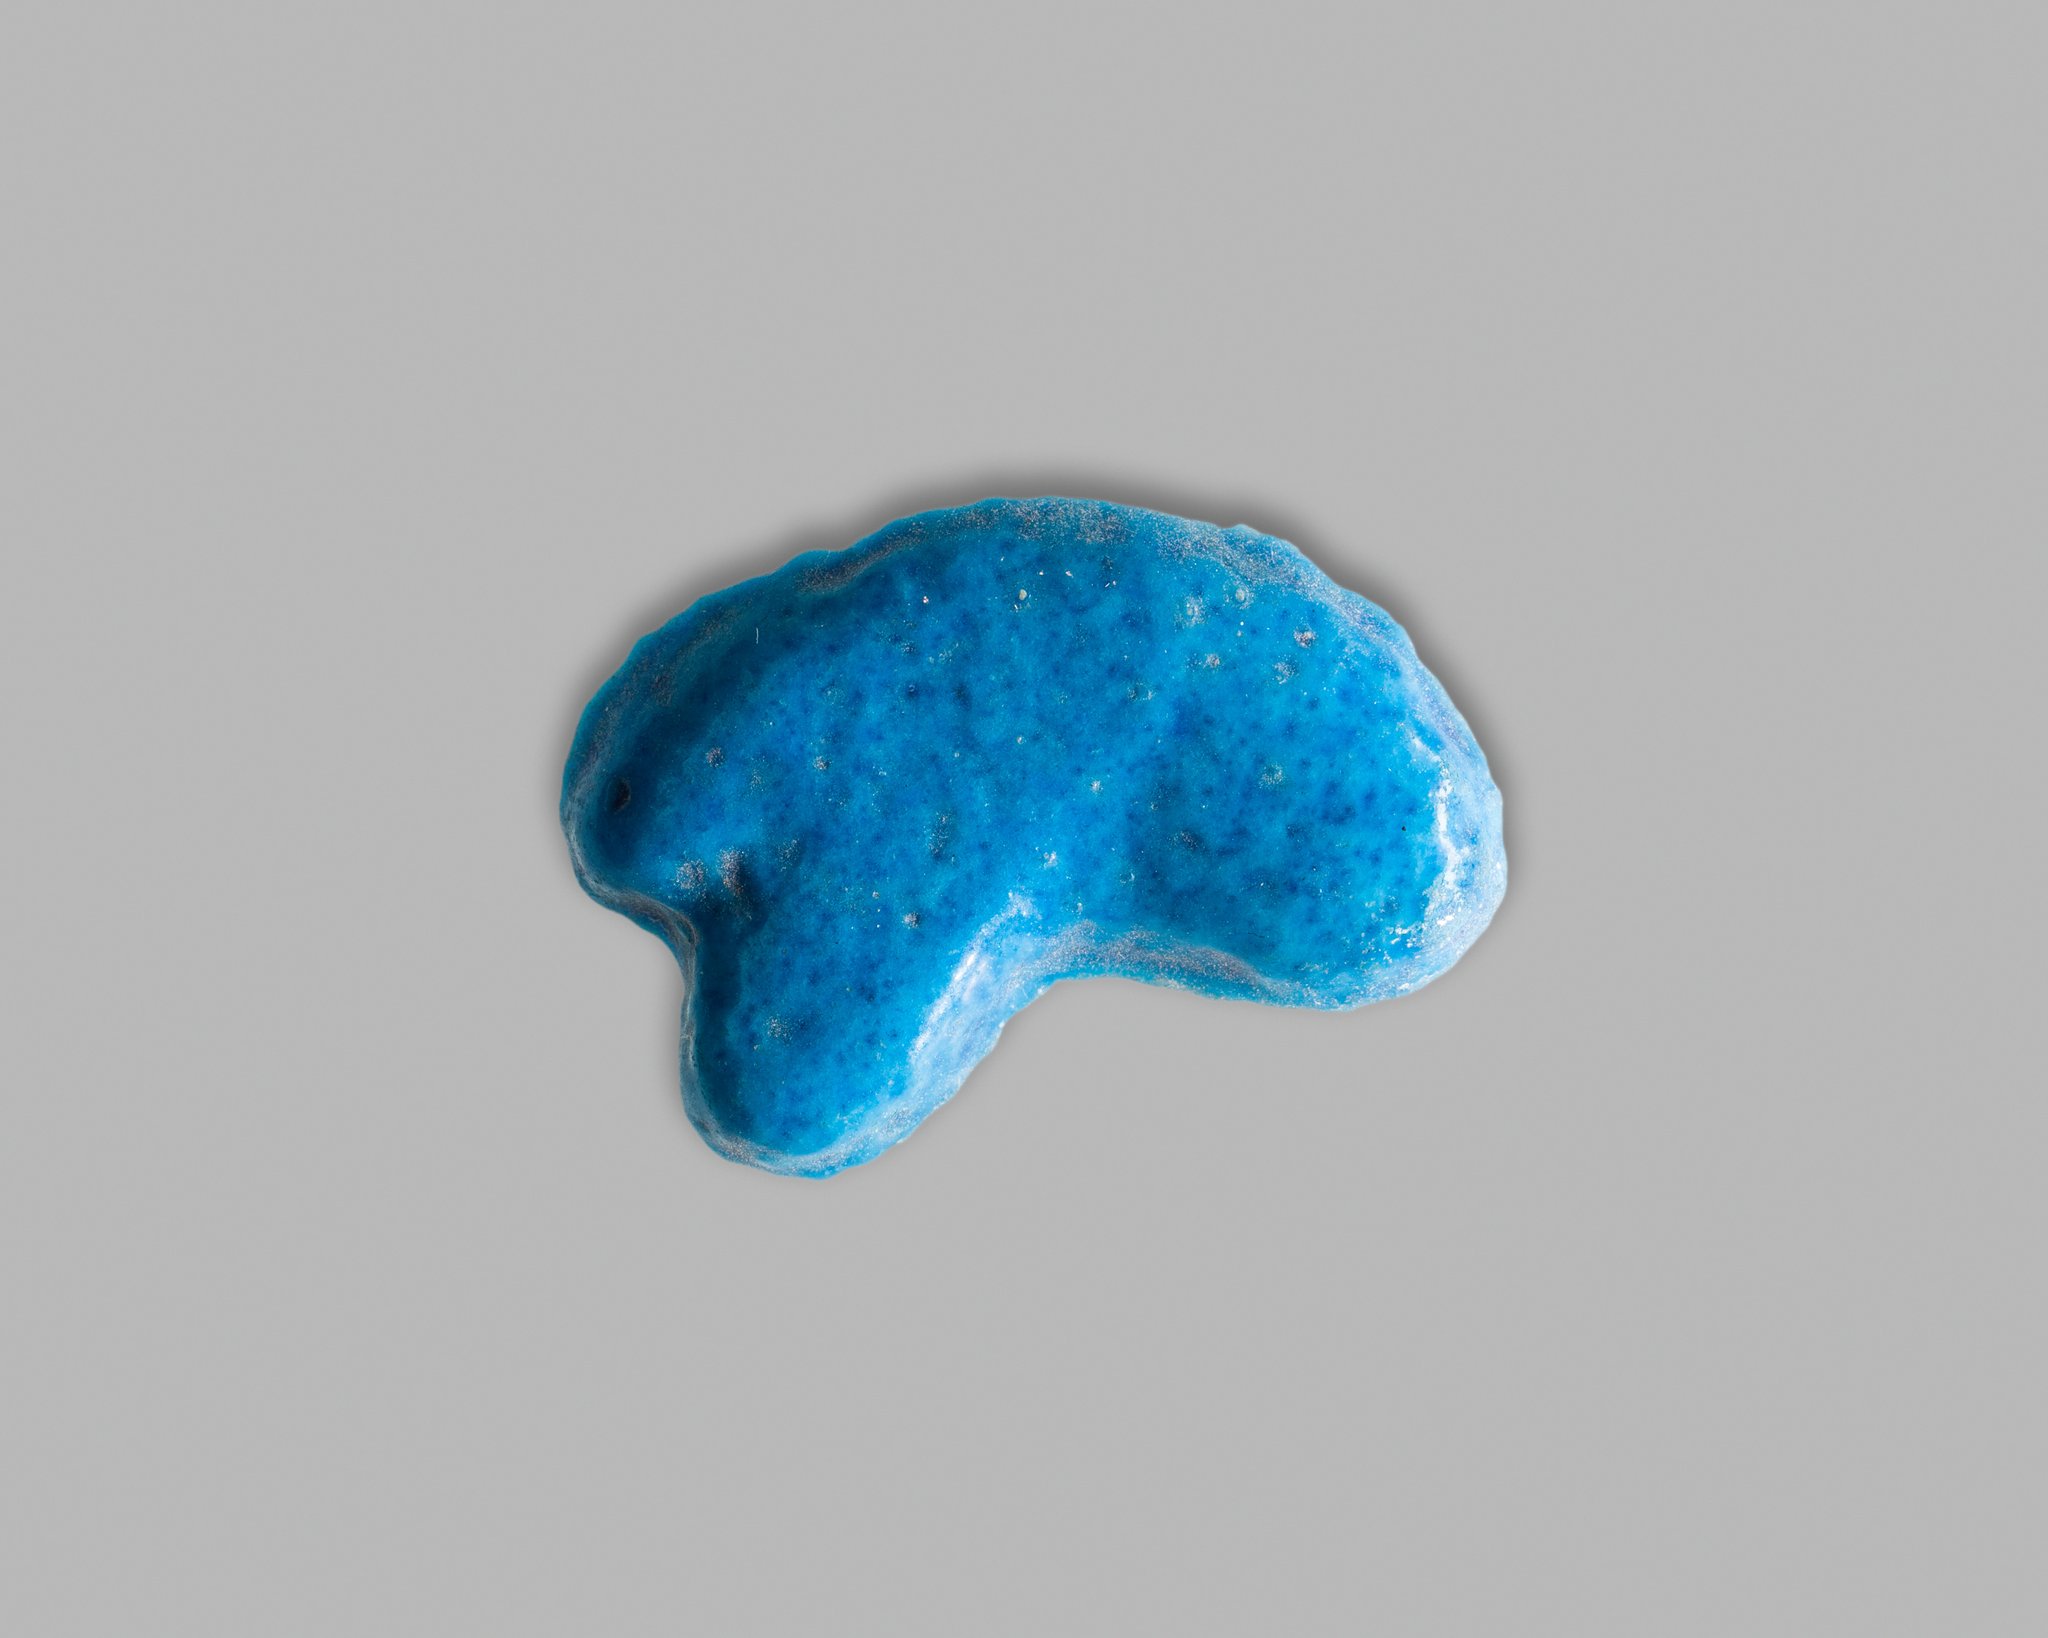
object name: foundation deposit plaque, rib, ramesses iv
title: Ribs-Shaped Plaque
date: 1153-1147 BCE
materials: faience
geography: egypt